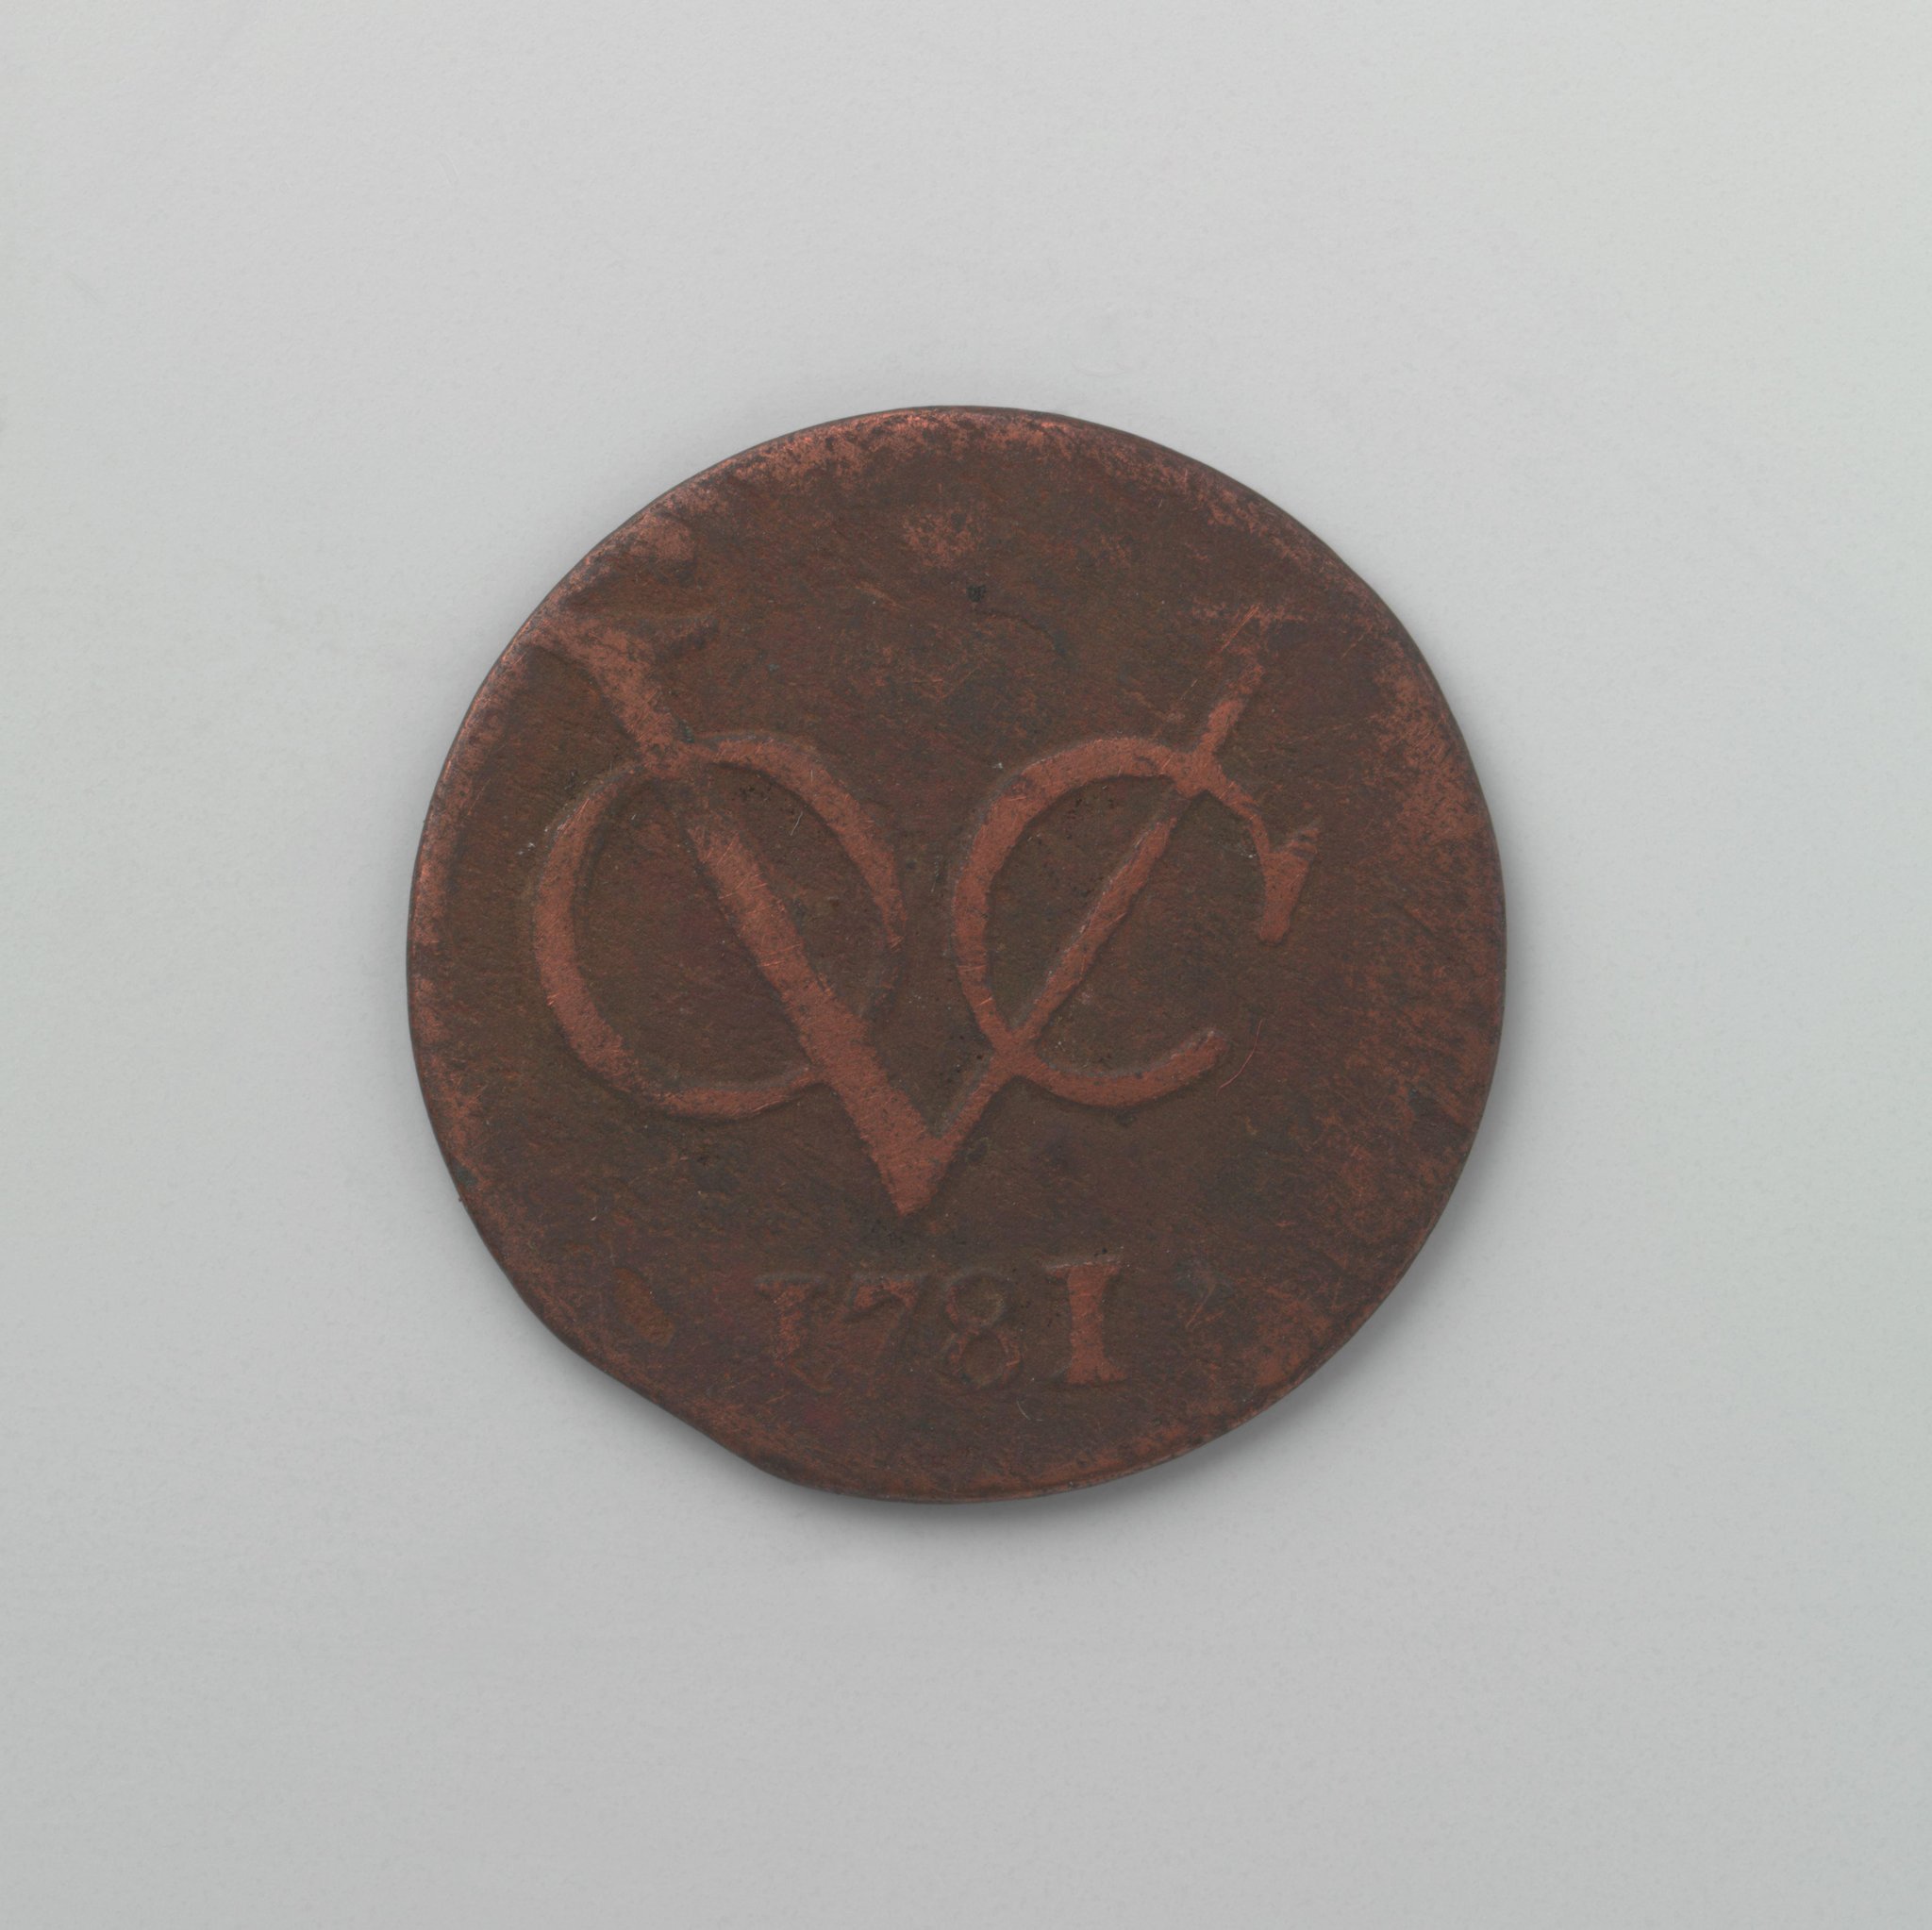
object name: coin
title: Duit van de VOC uit Westfriesland,1781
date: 1781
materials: copper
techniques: striking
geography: medemblik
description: Koperen munt. Voorzijde: gekroond wapenschild van Westfriesland. Keerzijde: monogram van de VOC, waarboven muntteken en waaronder jaartal. Gladde rand.